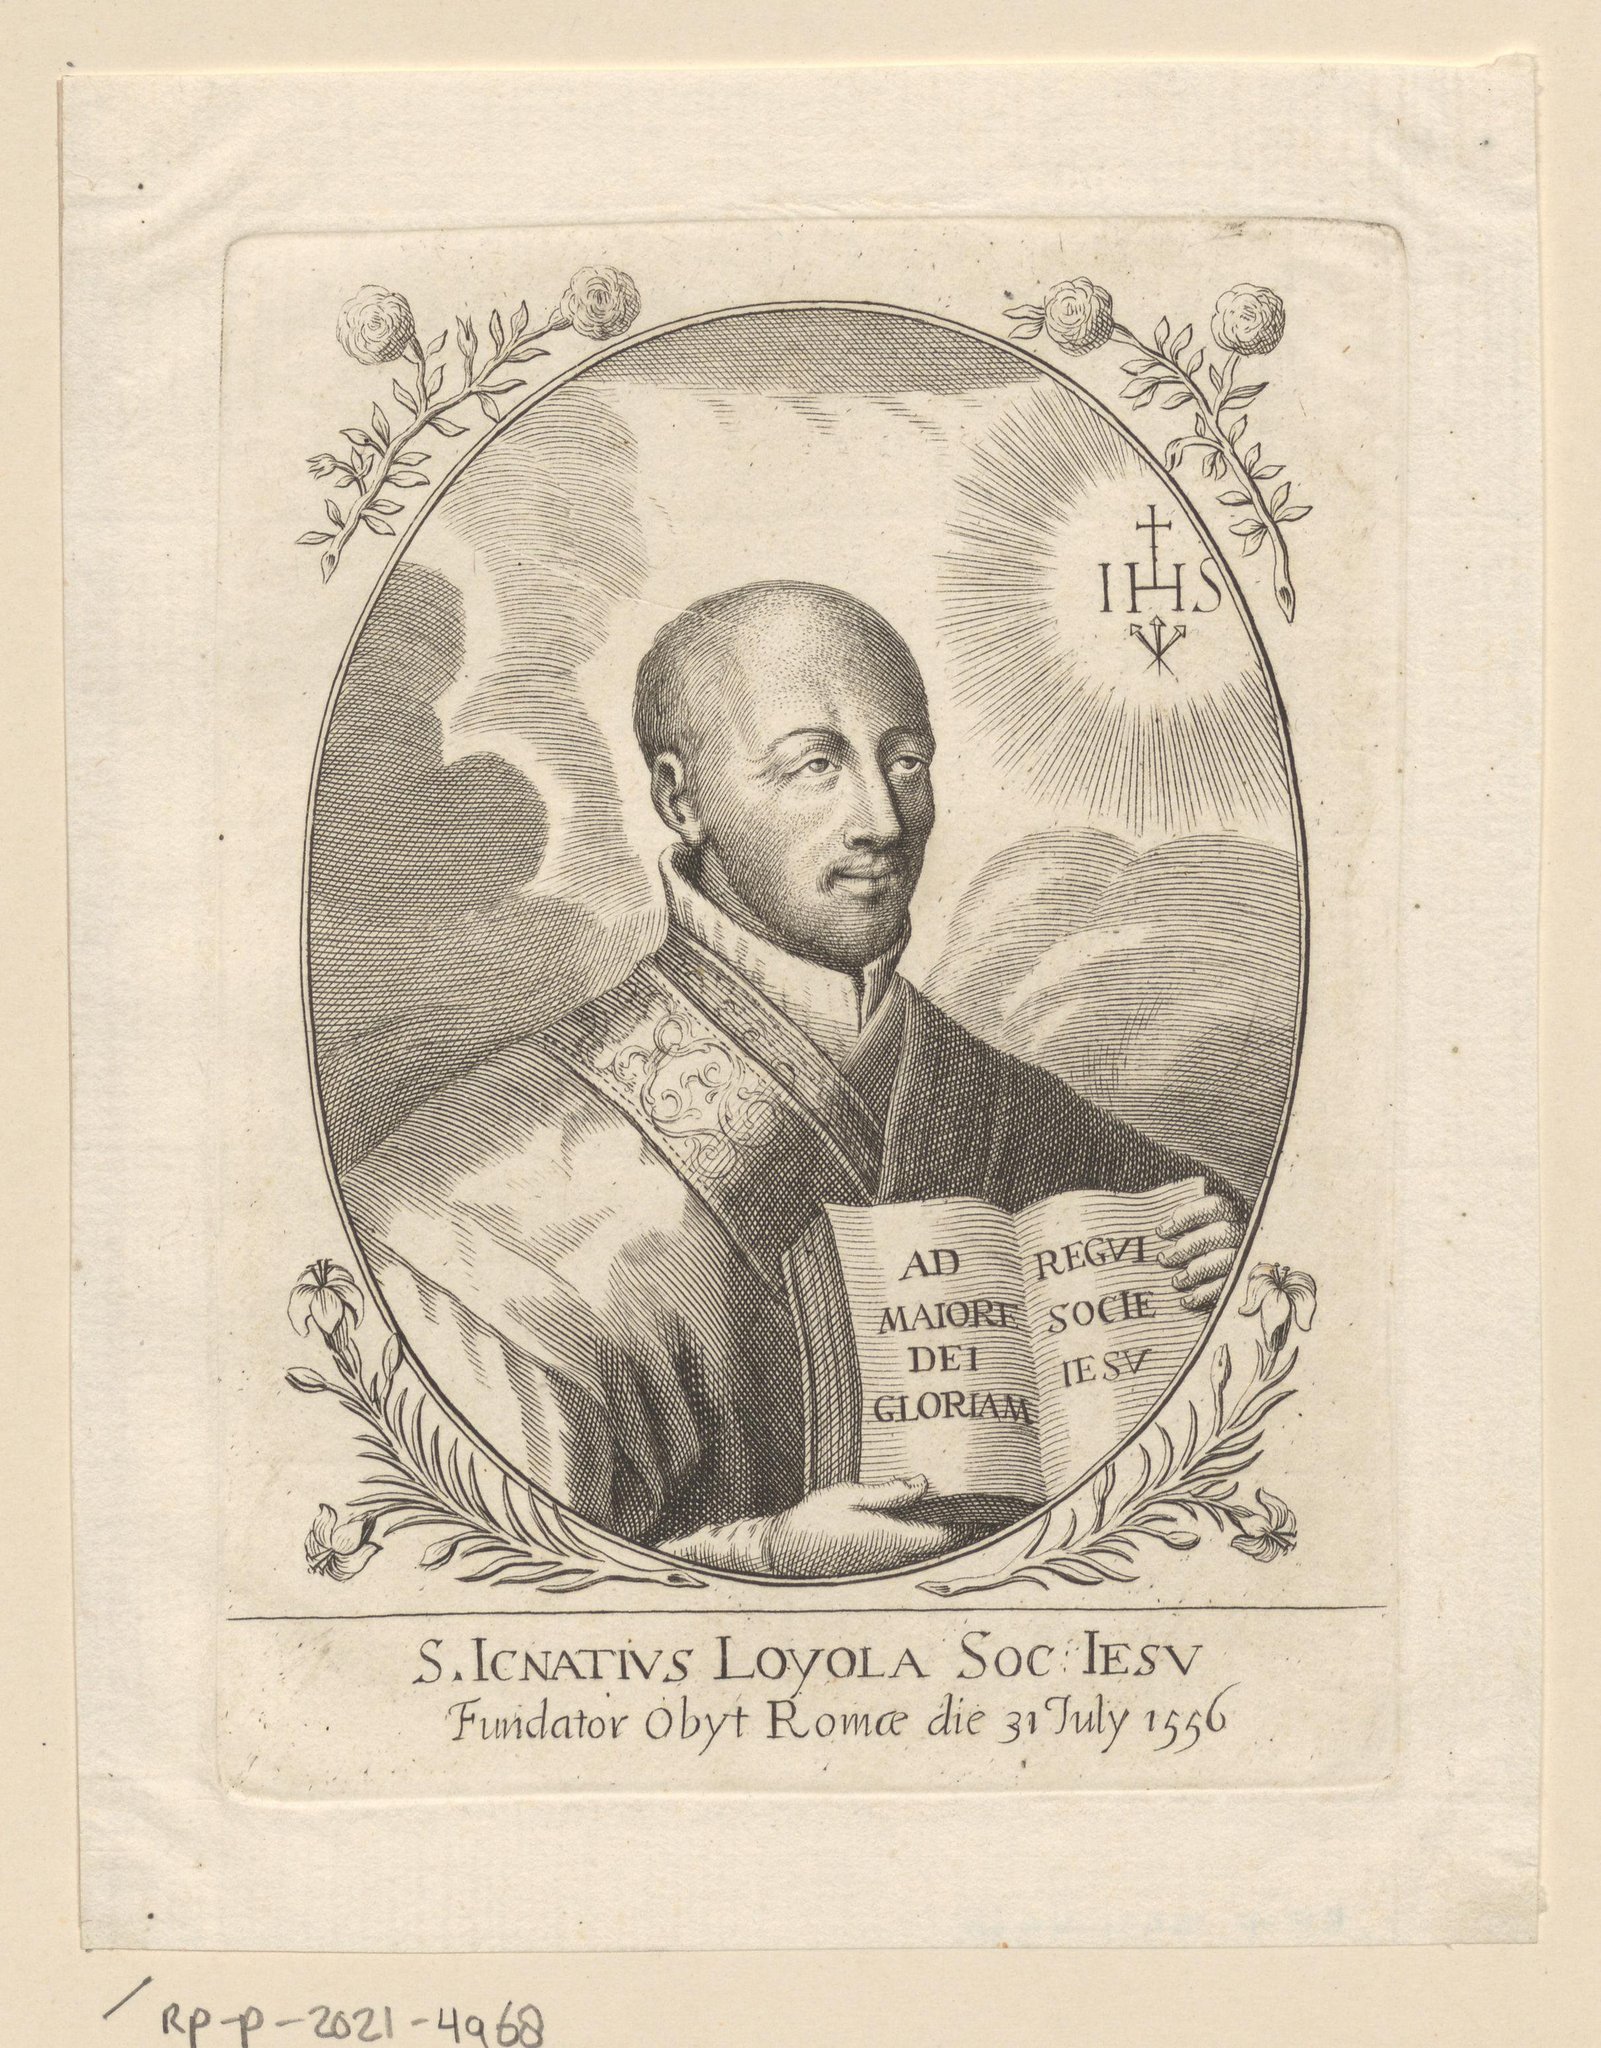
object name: print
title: Portret van Ignatius van Loyola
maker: Anonymous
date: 1650-1750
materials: paper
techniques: engraving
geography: france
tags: rome, clergyman, historical persons, the founder of the jesuit order, ignatius of loyola; possible attributes: book (with 'ad majorem dei gloriam'), demon, dragon under feet, flames, flaming heart, globe, ihs monogram, skull (with crown), tears in eyes, torch, flowers: rose